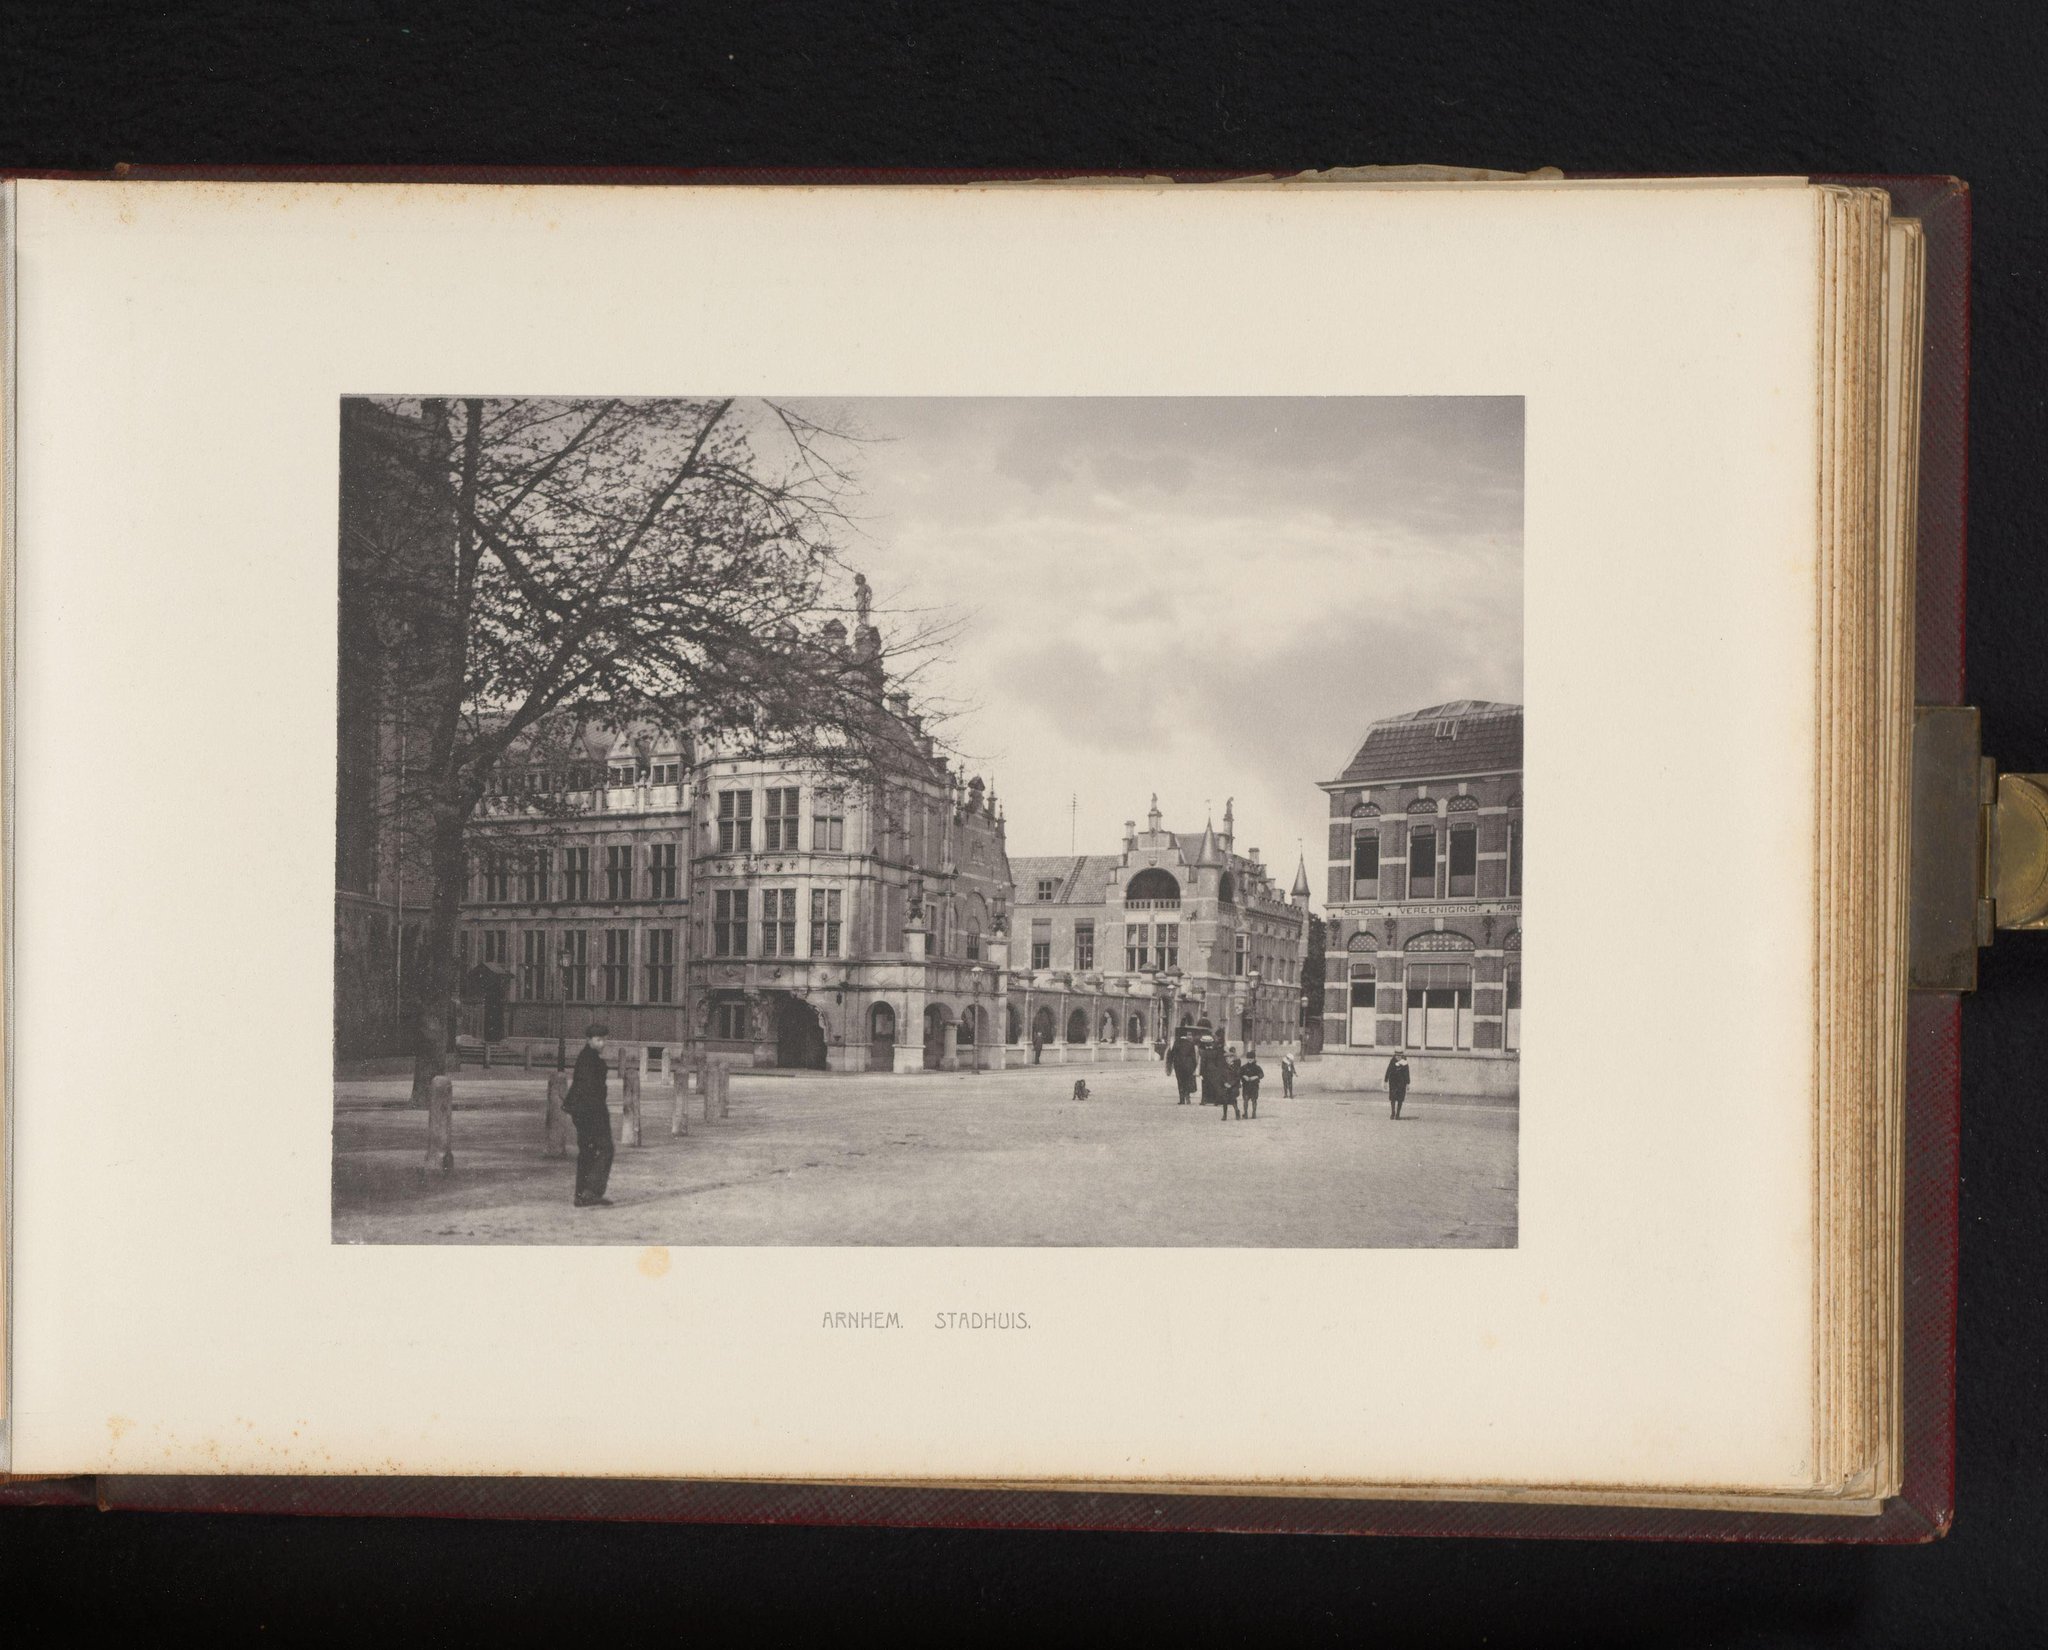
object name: photomechanical print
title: Gezicht op het Duivelshuis te Arnhem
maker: Anonymous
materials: paper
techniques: photograph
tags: square, place, circus, etc., historical persons, townhall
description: Deze pagina maakt deel uit van een album.